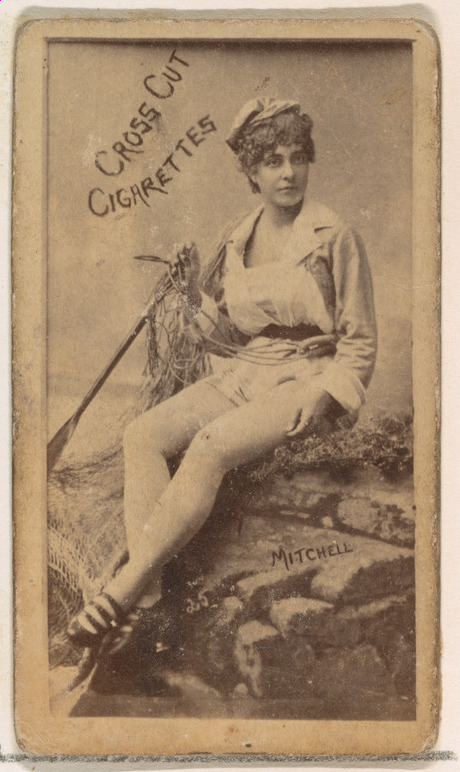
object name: print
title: Card Number 25, Mitchell, from the Actors and Actresses series (N145-1) issued by Duke Sons & Co. to promote Cross Cut Cigarettes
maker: w. duke, sons & co.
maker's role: publisher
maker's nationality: american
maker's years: 1870-1920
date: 1880-1889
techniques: albumen silver print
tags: portraits,women,actresses